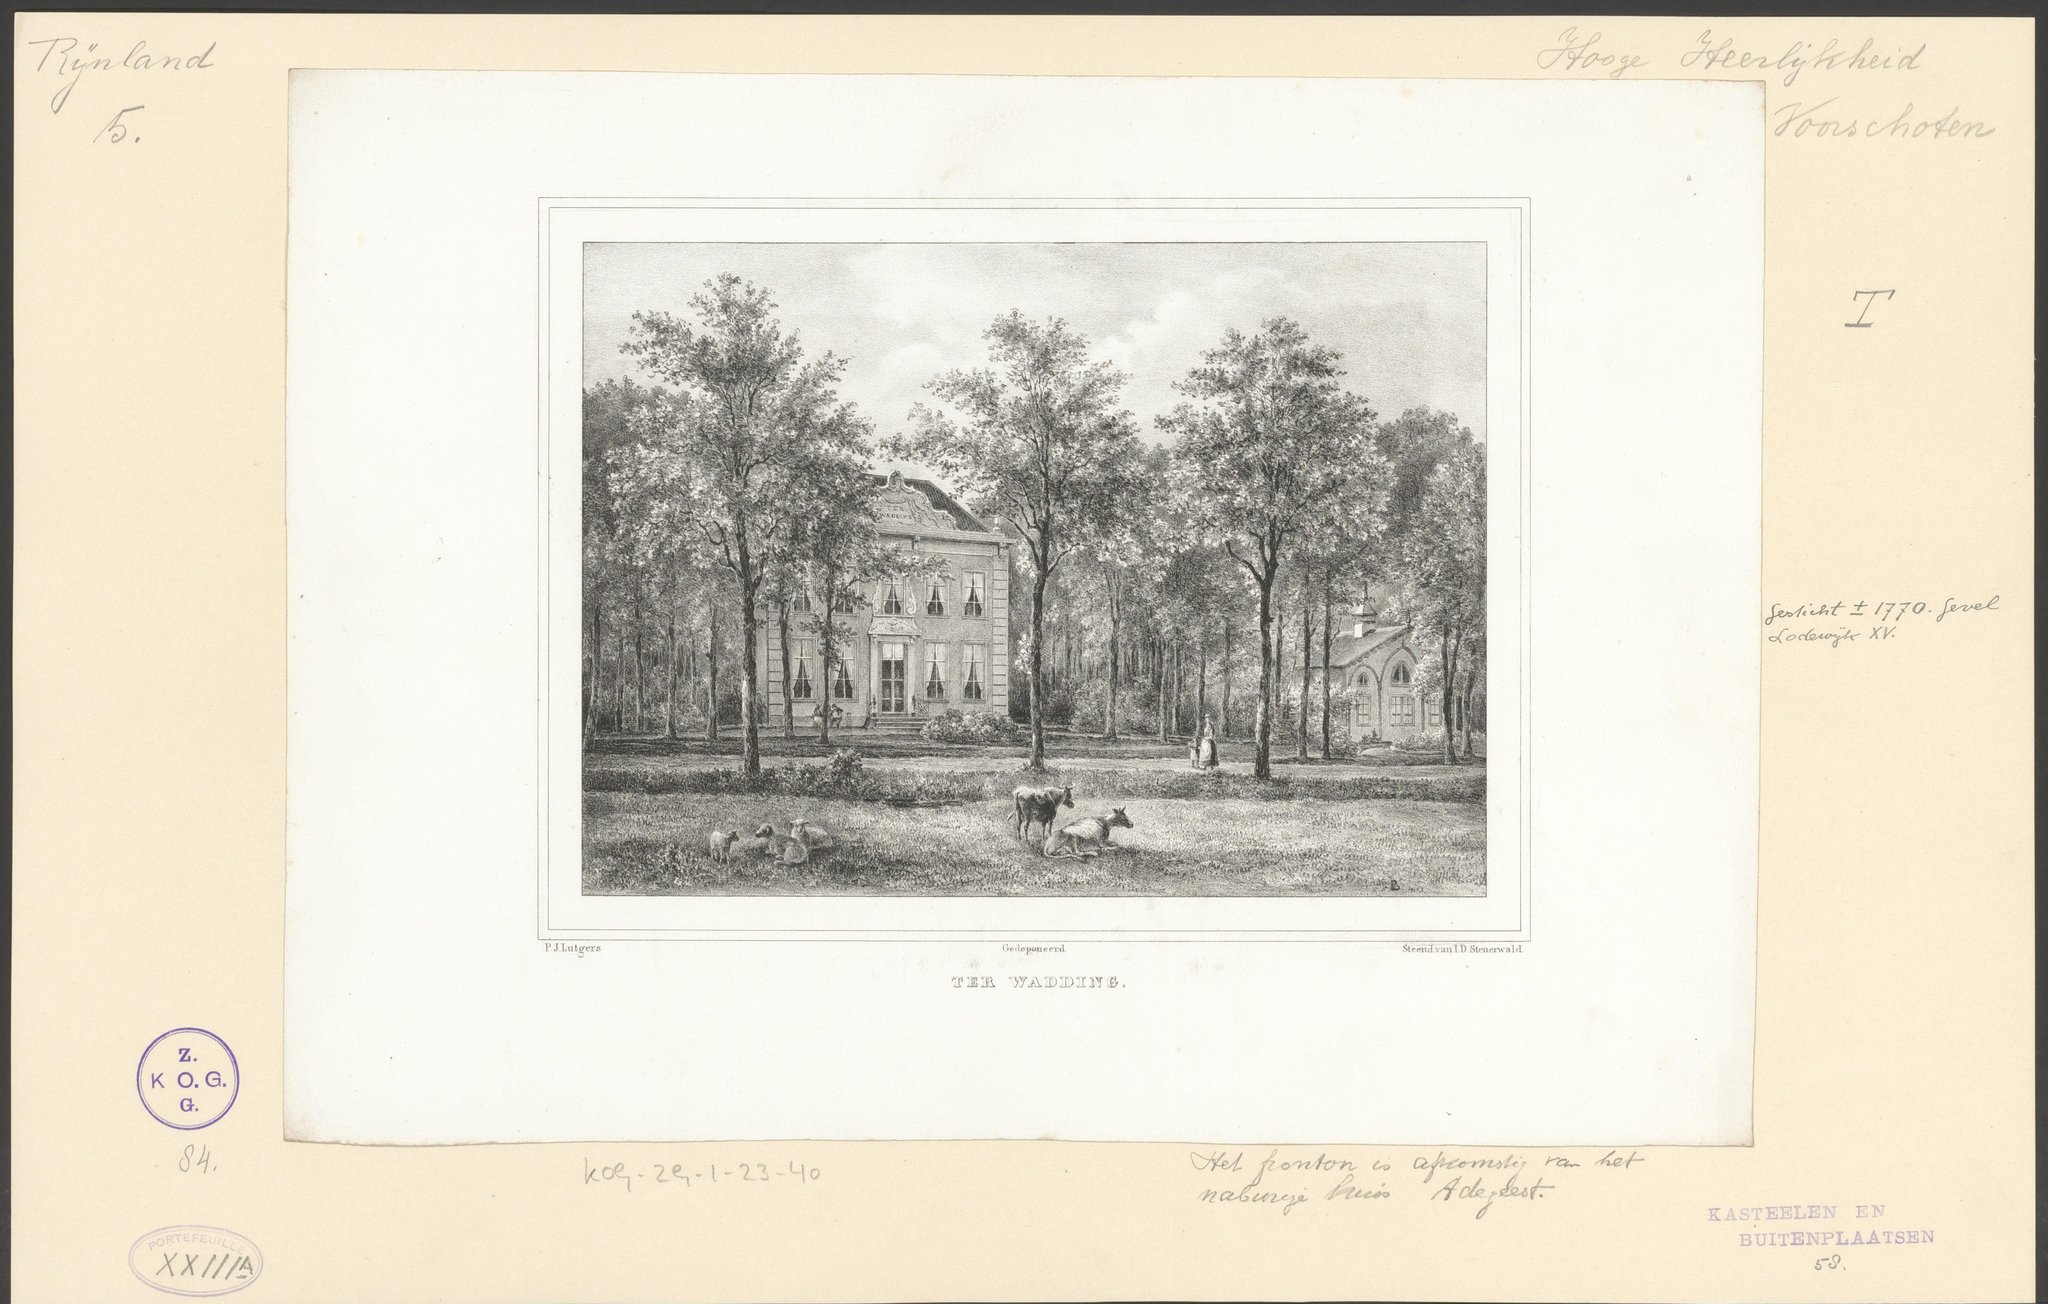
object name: print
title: Gezicht op Huis ter Wadding te Voorschoten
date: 1855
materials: paper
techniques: lithograph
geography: the hague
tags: trees, farm or solitary house in landscape, voorschoten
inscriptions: stamp, collector's mark: Lugt 1641, stamp, : ‘Gedeponeerd’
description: Onderwerpsrubrieken binnen de Atlas Zeden en Gewoonten: Zeden en Gewoonten in Engeren Zin, De Woning. Kastelen en buitenplaatsen. Holland.